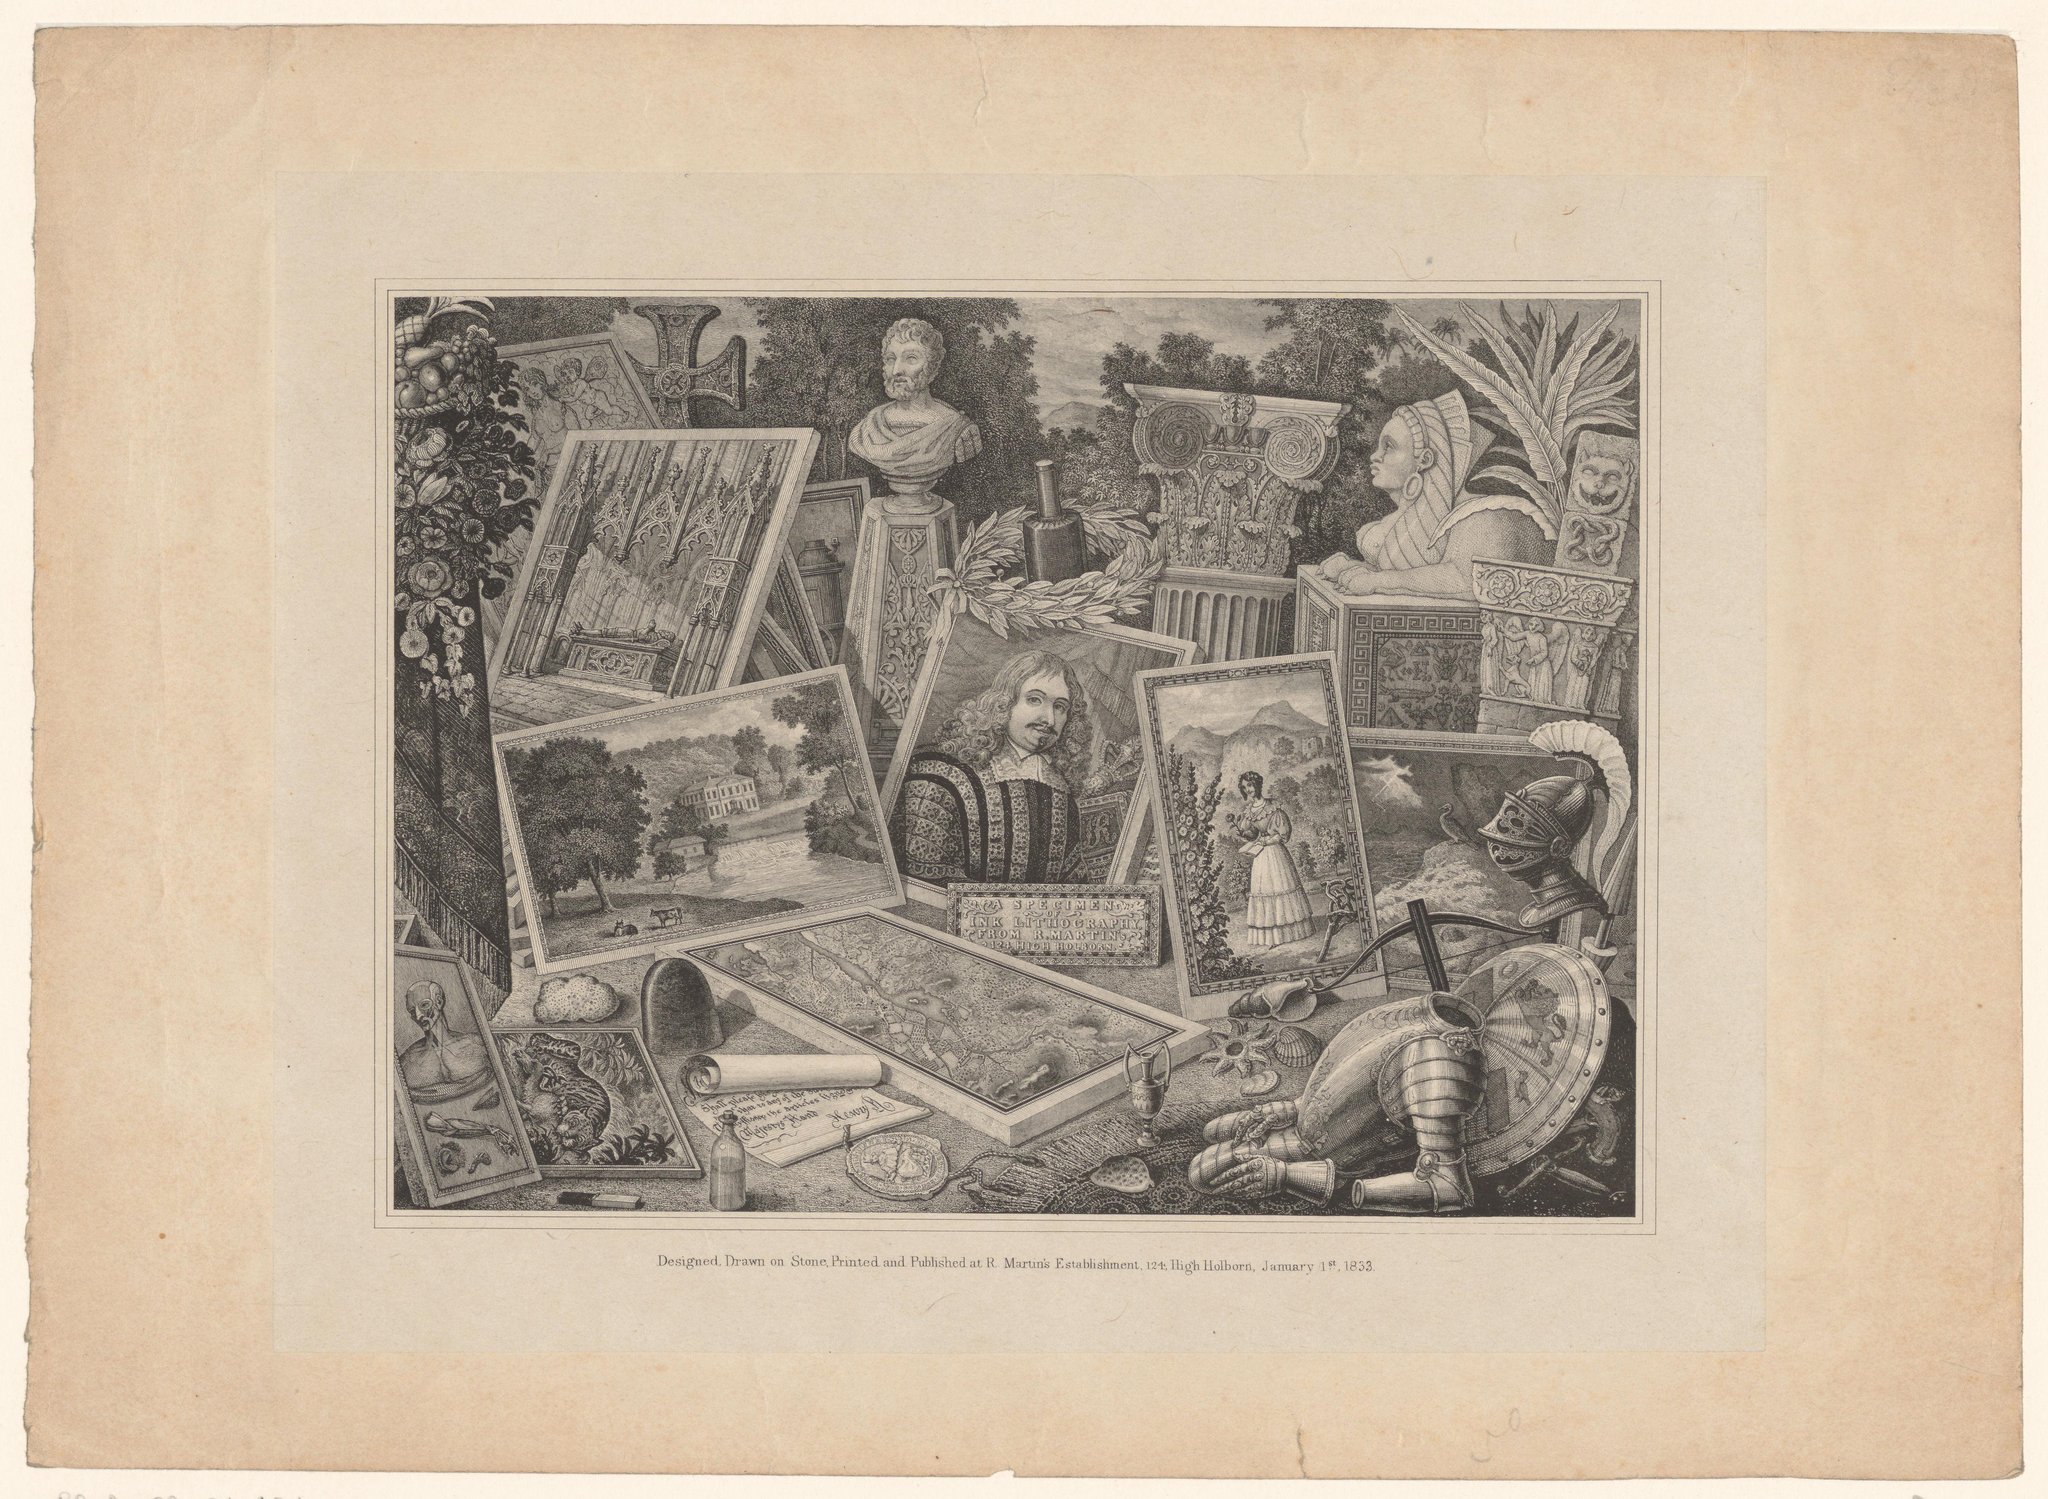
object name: print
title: Diverse kunstobjecten bij elkaar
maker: robert martin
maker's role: print maker, printer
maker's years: 1770-1838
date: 1833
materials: paper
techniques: lithograph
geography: london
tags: still life of related objects, picture, painting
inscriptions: date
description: Advertentie voor de werkplaats van Robert Martin en het werk dat zij uitvoerden.